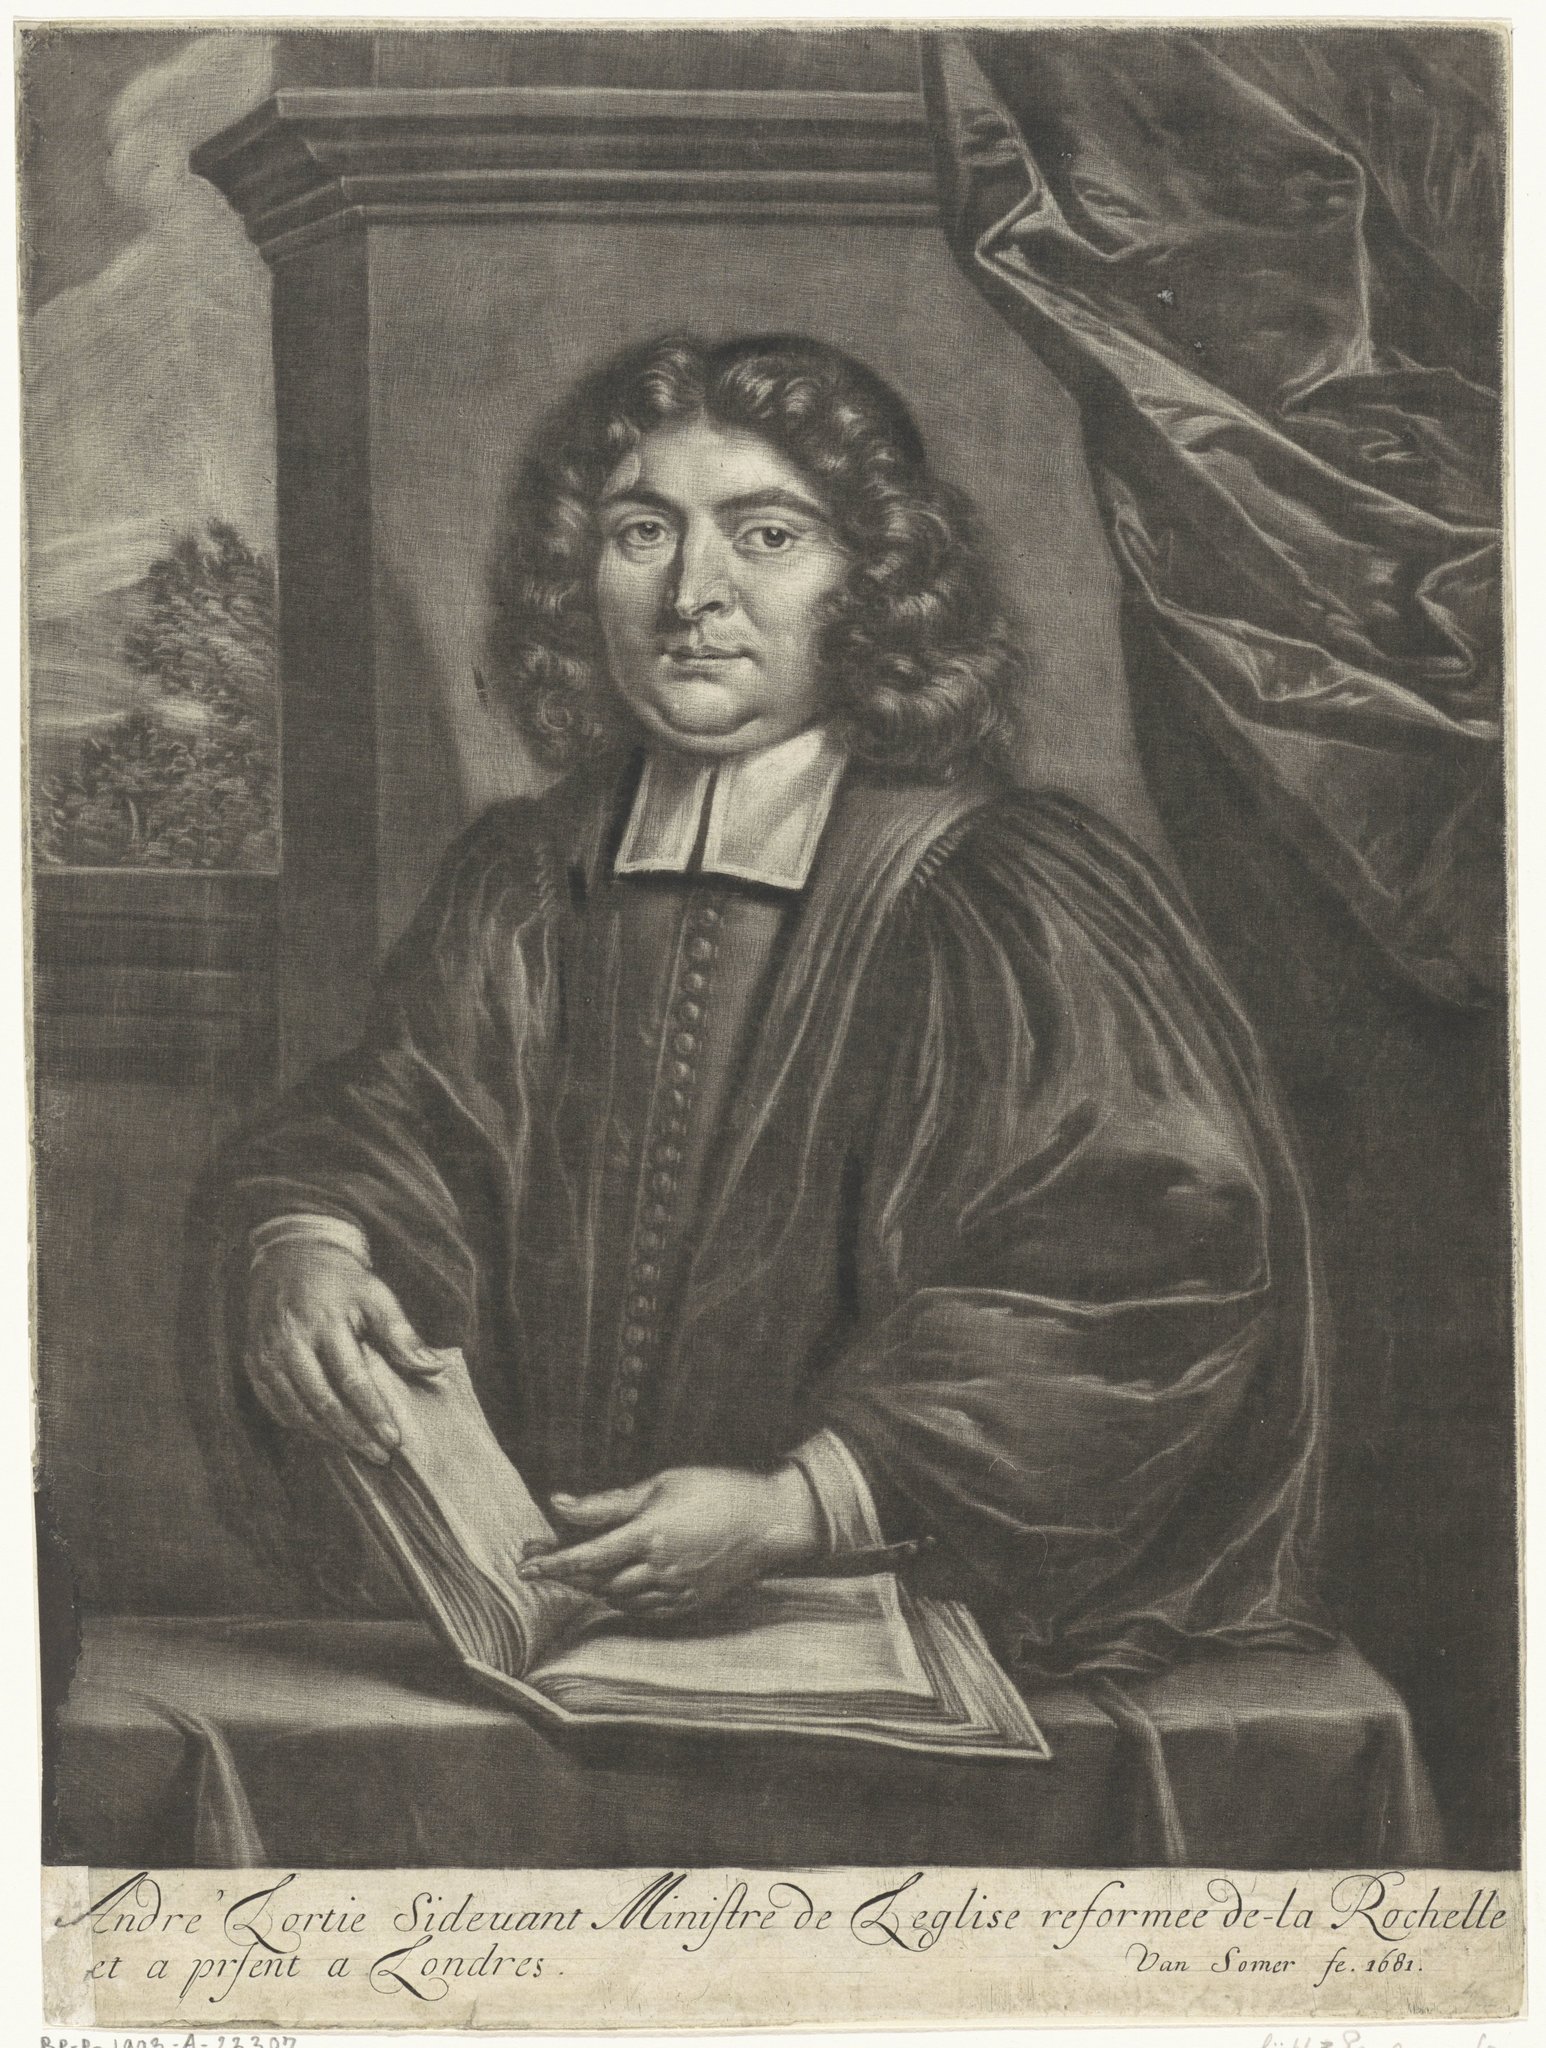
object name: print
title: Portret van André Lortie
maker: paul van somer (ii)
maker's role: draughtsman, print maker, publisher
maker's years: 1639-1704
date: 1681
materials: paper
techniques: engraving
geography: london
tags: landscapes, book - mm - book open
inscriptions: collector's mark: Lugt 2228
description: De Franse theoloog en minister in Engeland André Lortie, bladert in een boek. Op de achtergrond een gordijn en een landschap.